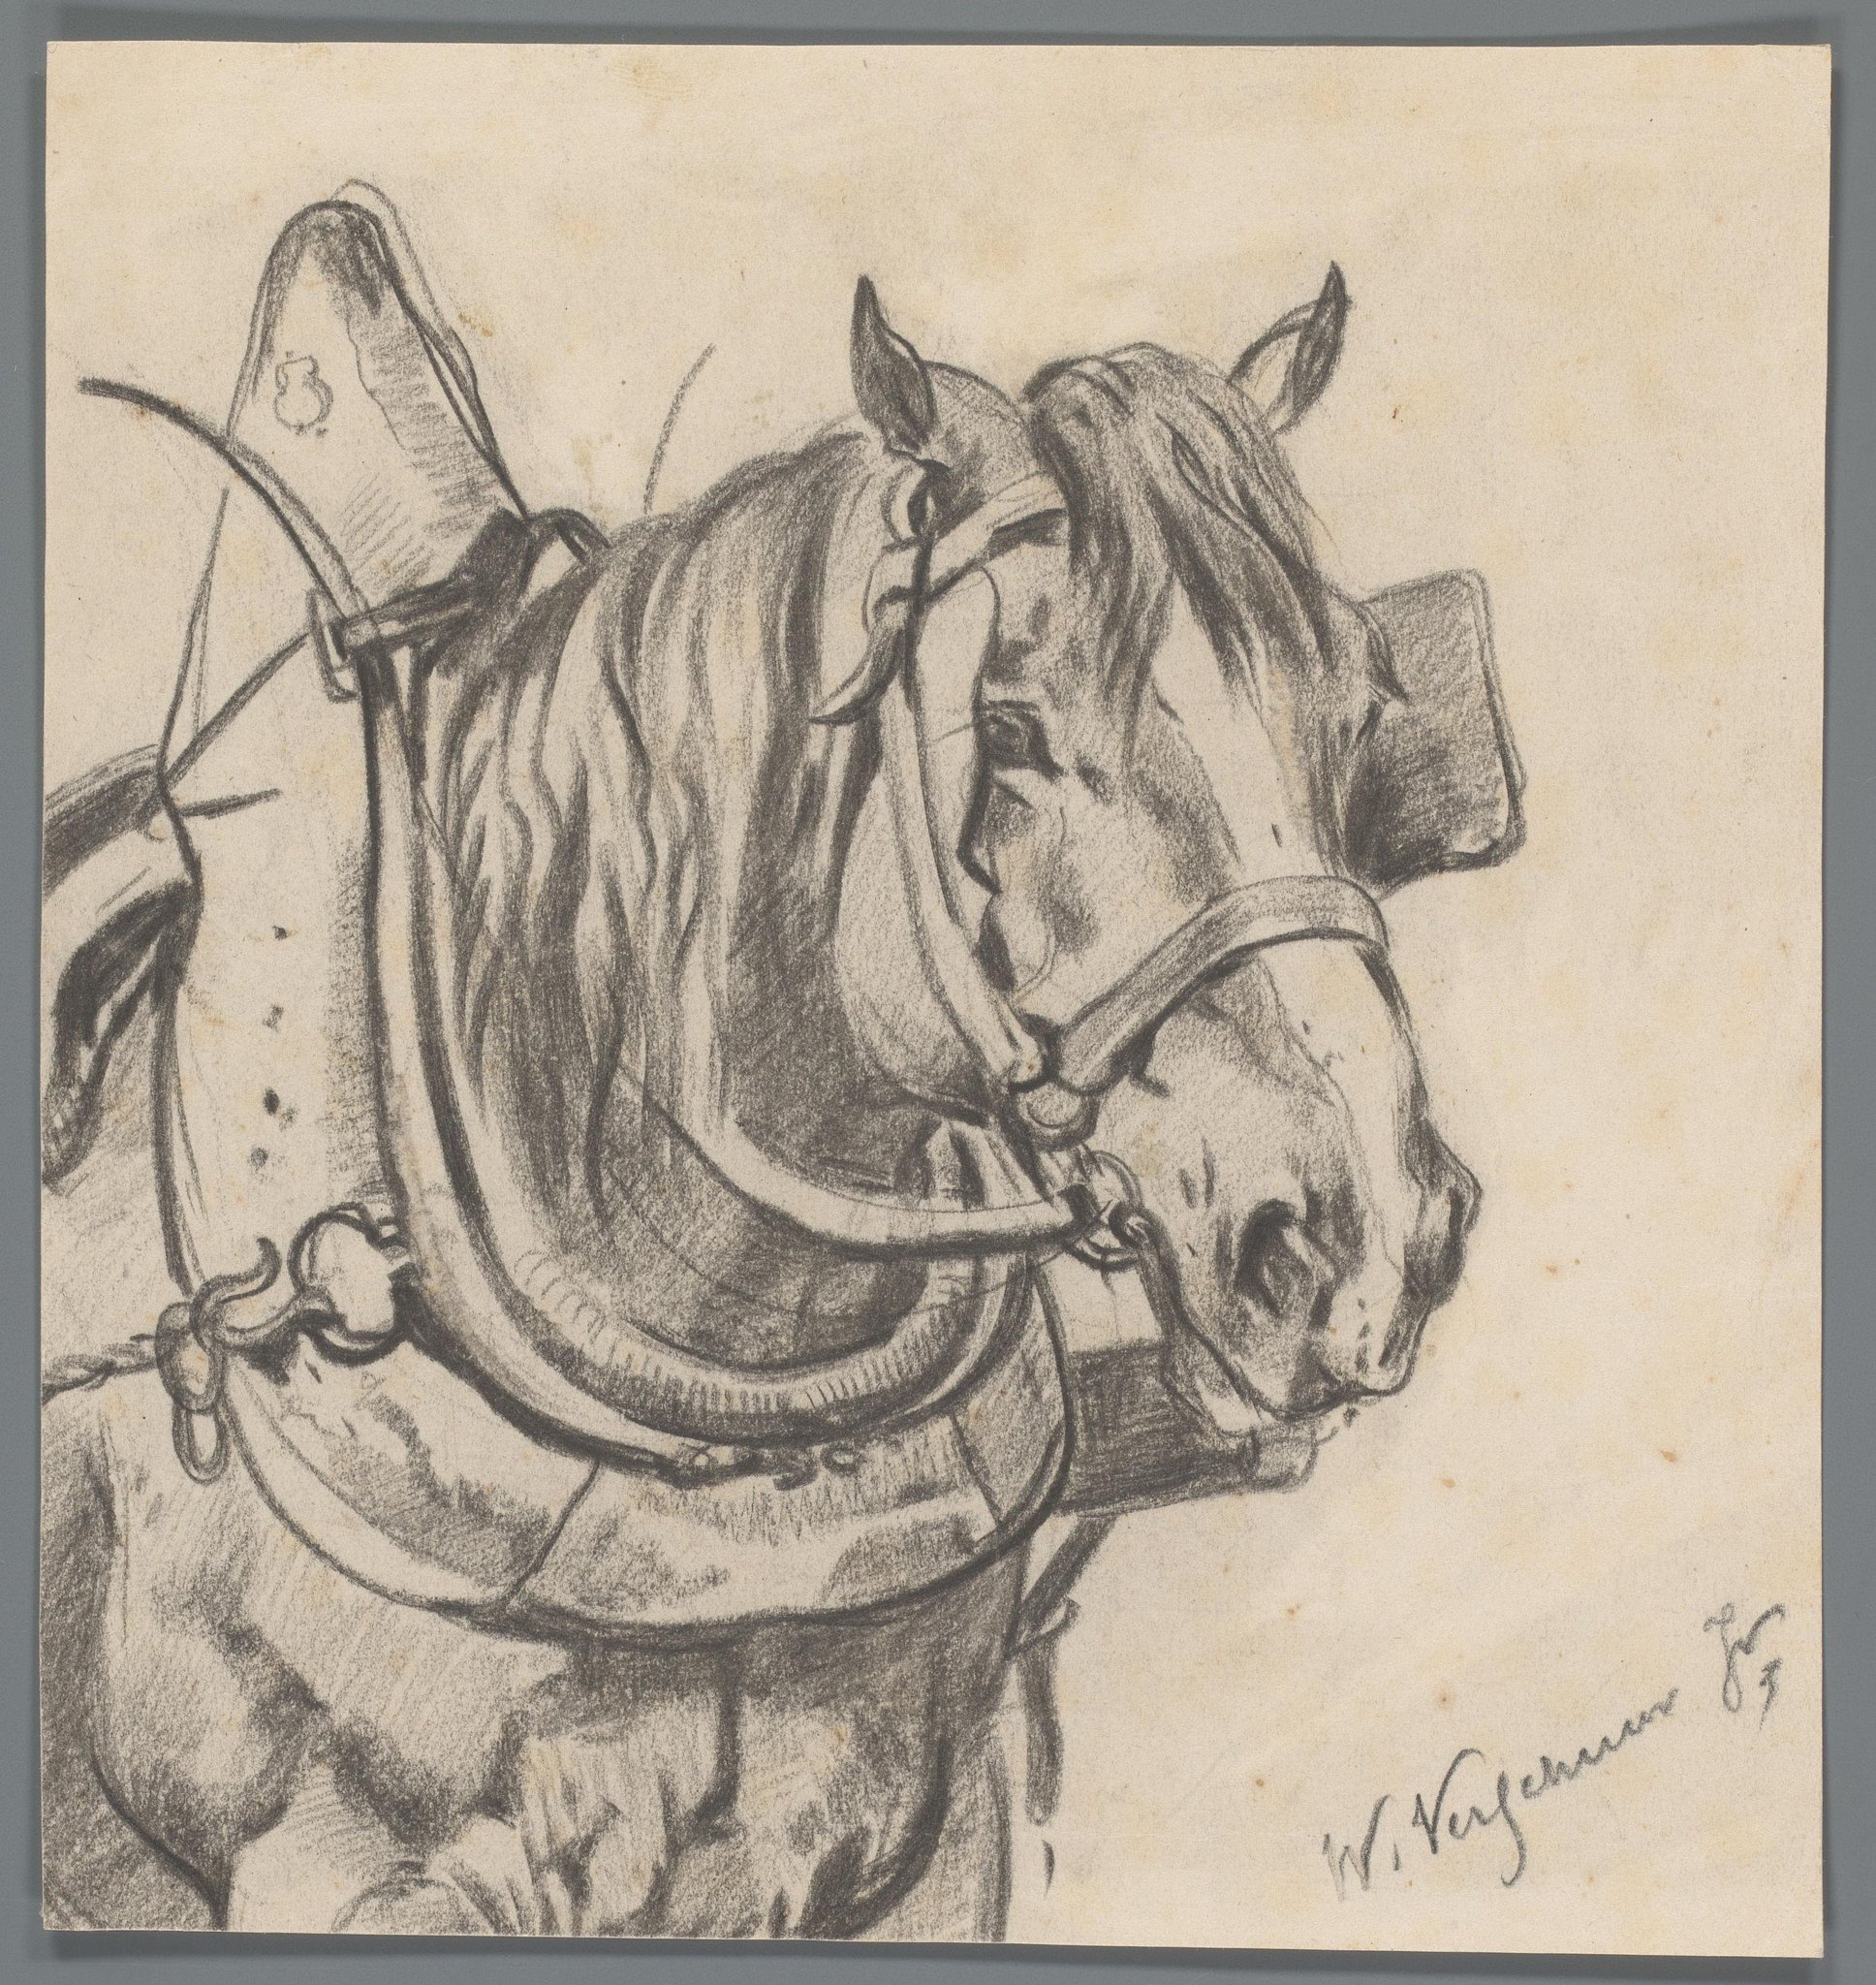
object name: drawing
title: Werkpaard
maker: wouter verschuur (1841-1936)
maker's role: draughtsman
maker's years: 1841-1936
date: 1894-1919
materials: chalk, paper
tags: horse